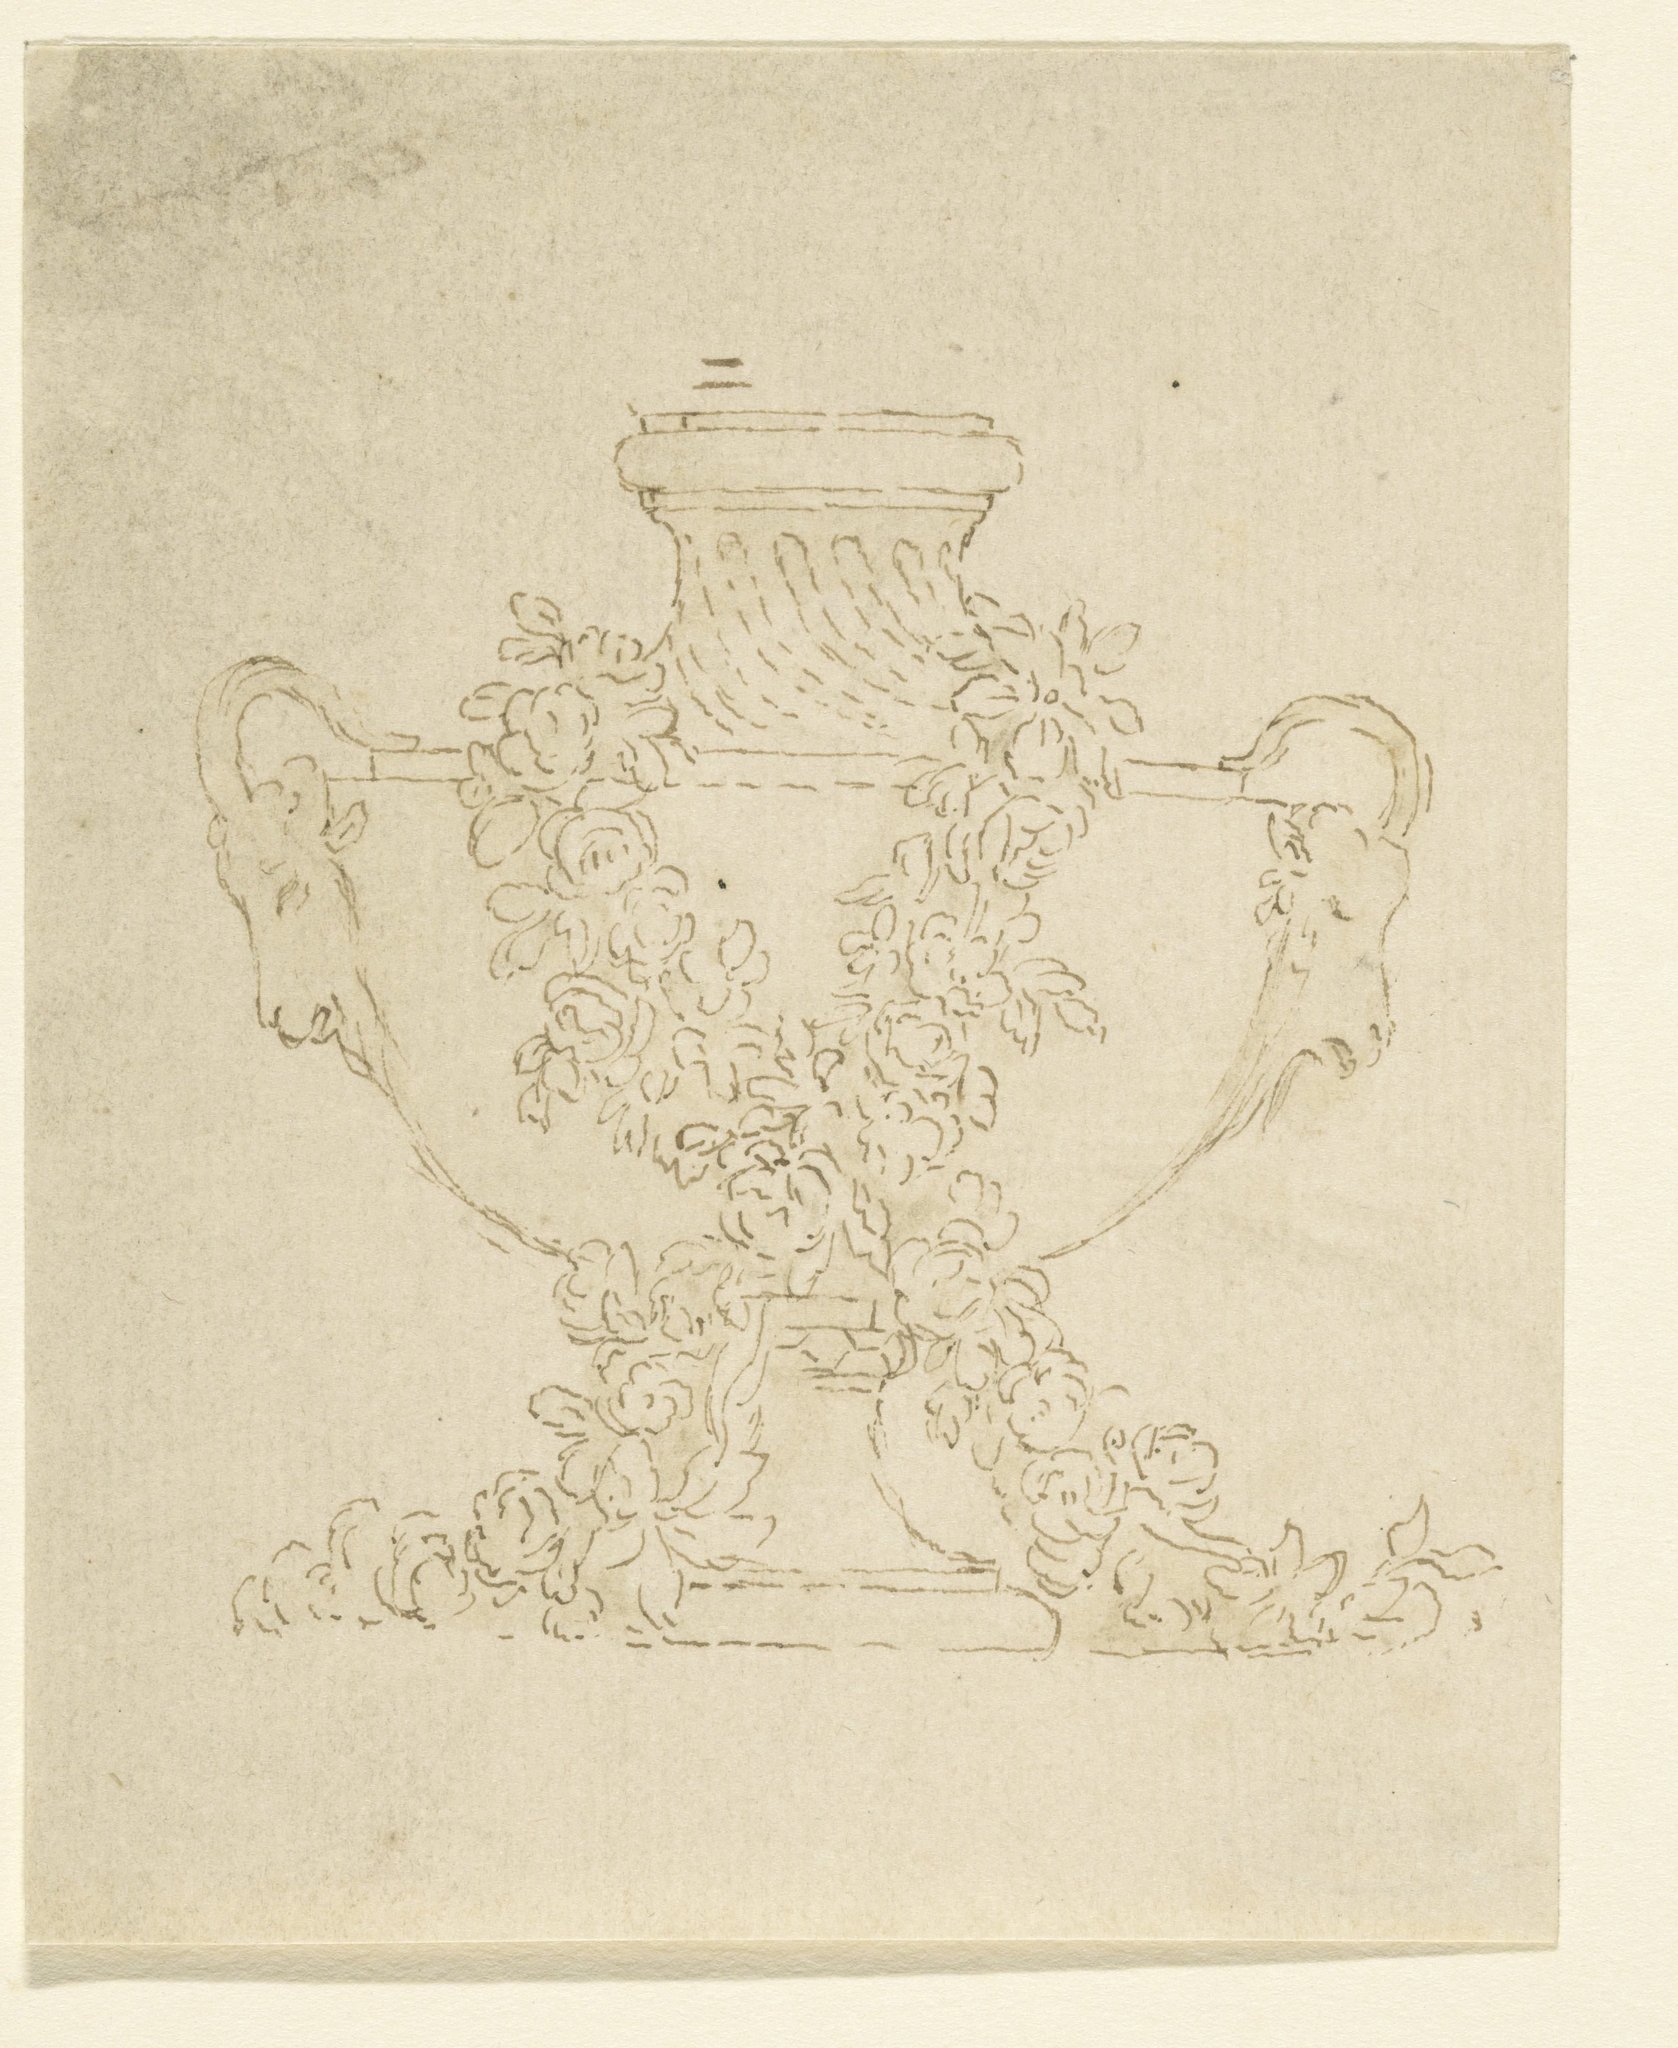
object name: drawing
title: Vaas met guirlande en geitenkoppen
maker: Anonymous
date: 1650-1800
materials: ink, paper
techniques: brush, pen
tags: vase ~ ornament, he-goat, billy-goat, ornament ~ festoon, garland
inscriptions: collector's mark: Lugt 2228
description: Een geornamenteerde vaas met een bloemguirlande en twee geitenkoppen als handvaten.